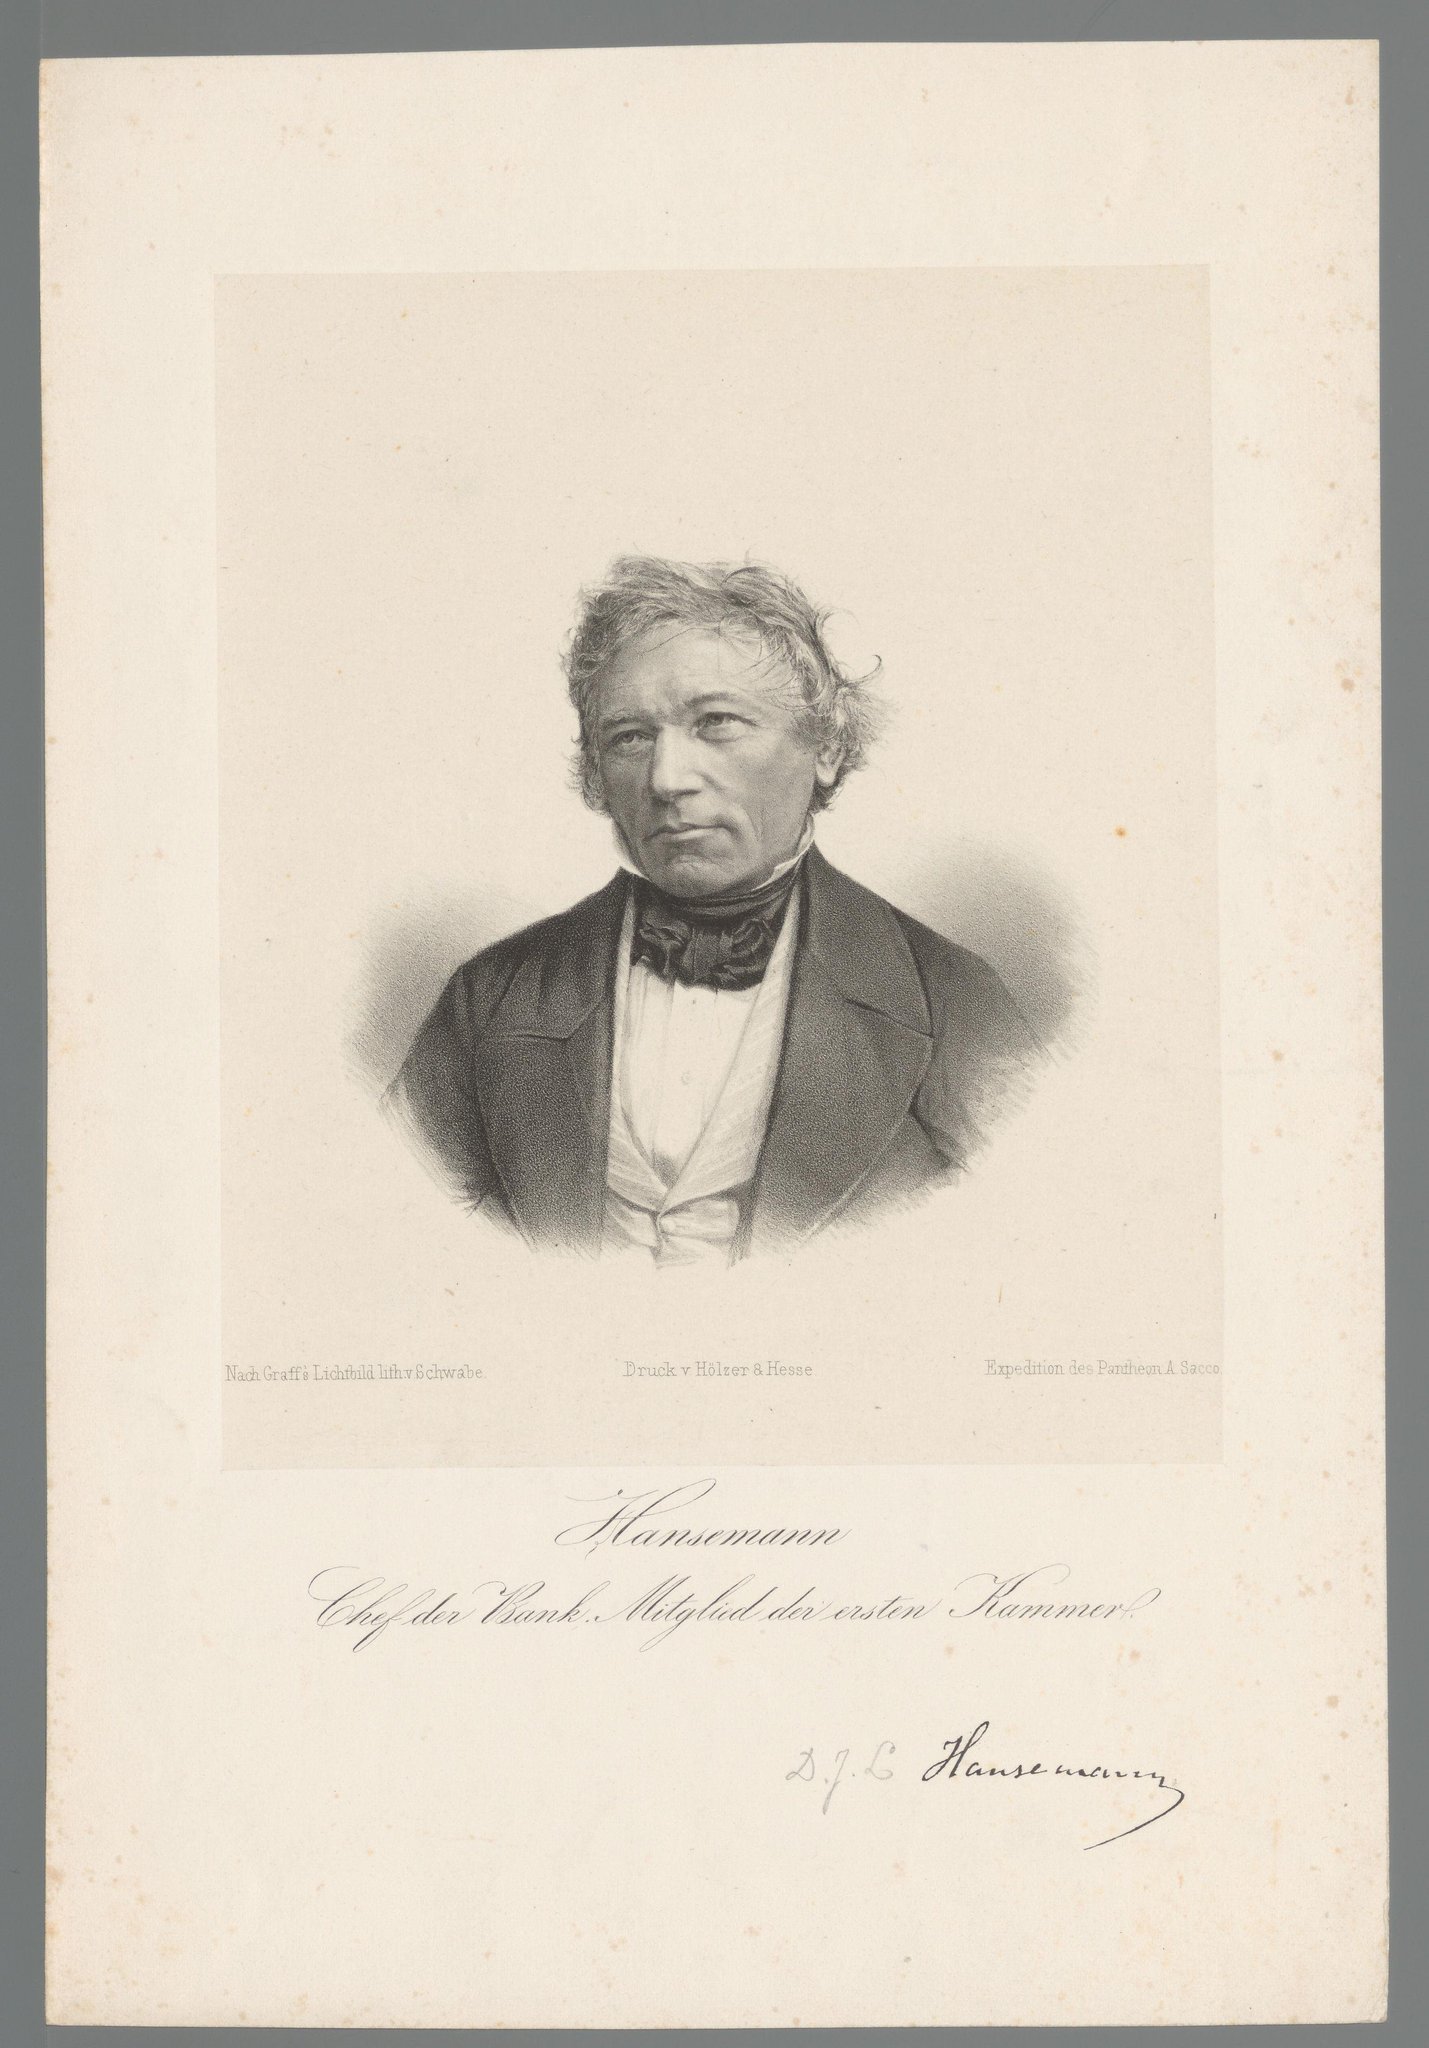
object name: print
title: Expedition des Pantheon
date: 1830-1860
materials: paper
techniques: lithograph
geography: berlin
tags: adult man, historical persons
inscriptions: collector's mark: Lugt 2228